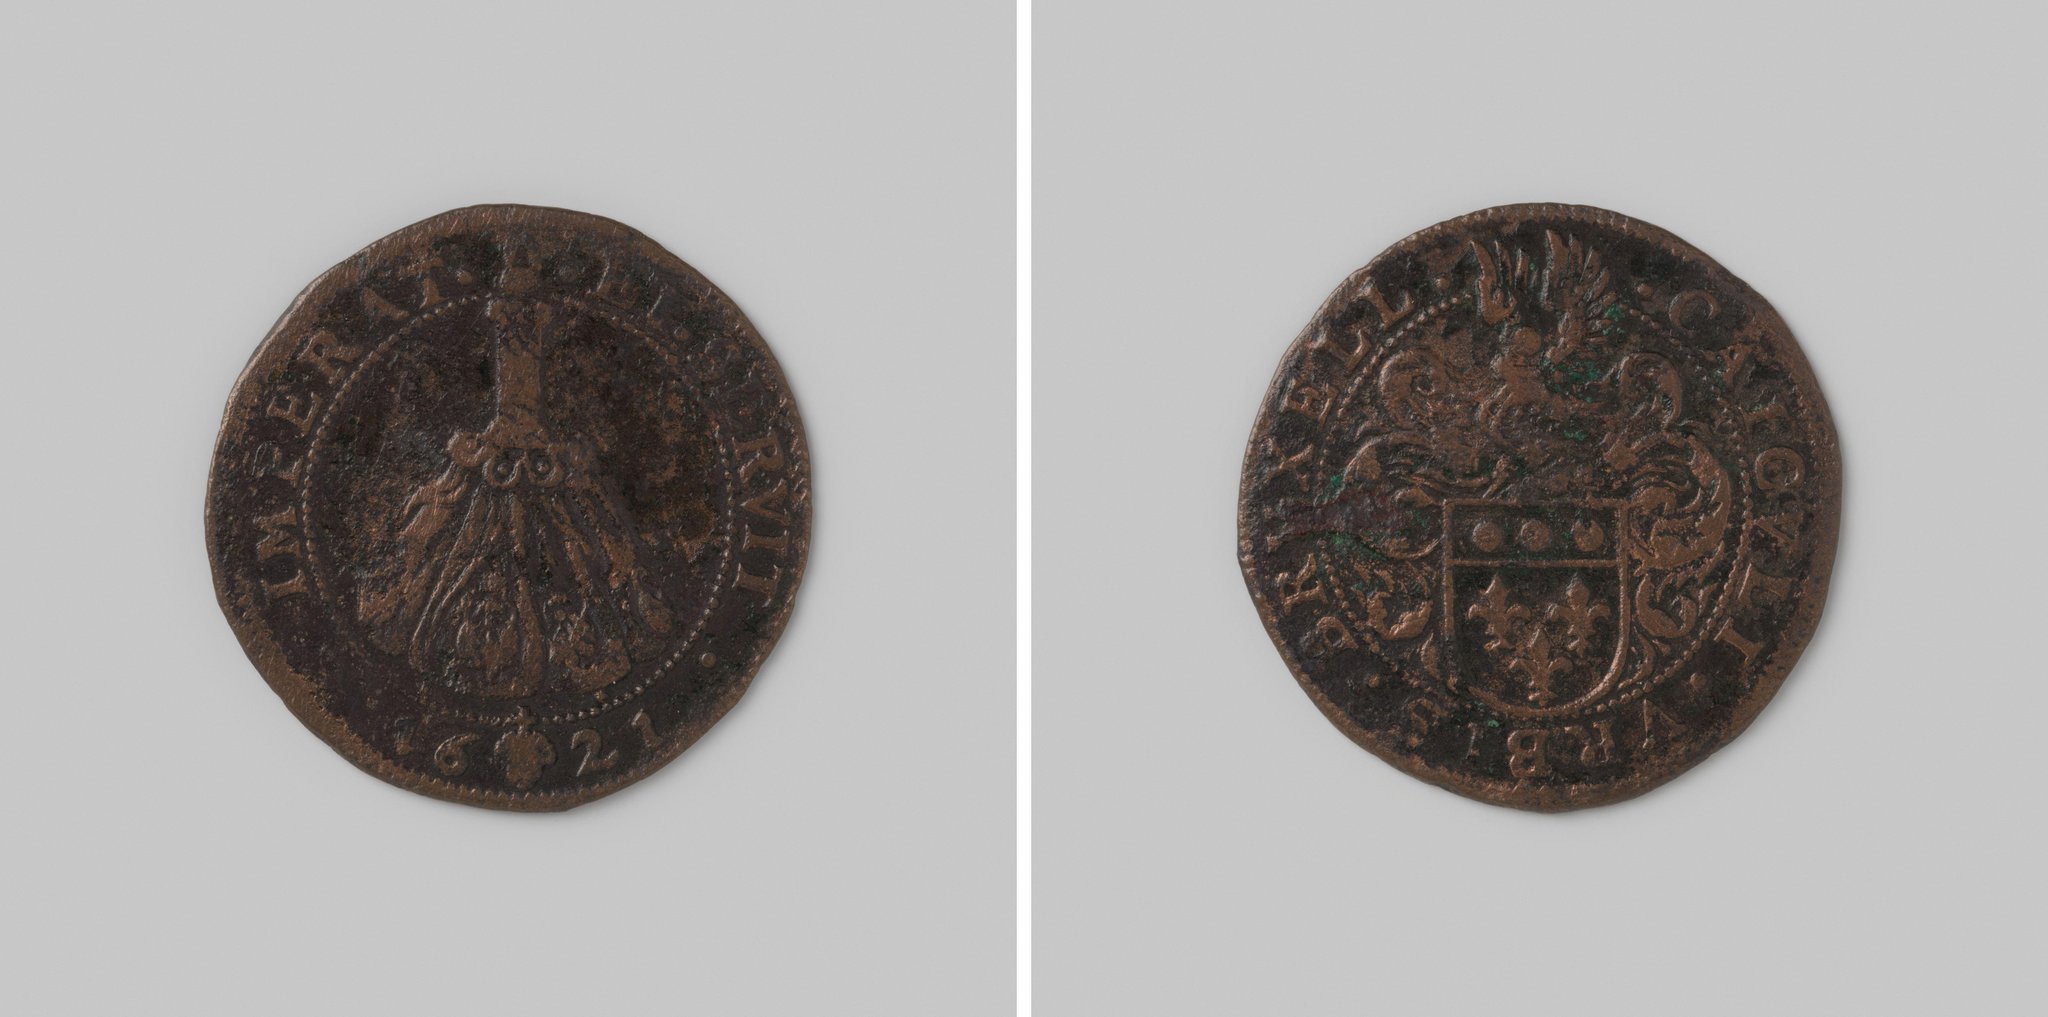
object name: jeton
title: Rekenpenning uit Brussel voor de stad Brussel op de geldhandel ? 1621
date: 1621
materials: copper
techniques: striking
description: Koperen penning, op de voorzijde een stokbeurs met omschrift, op de keerzijde een gehelmd wapenschild met omschrift.